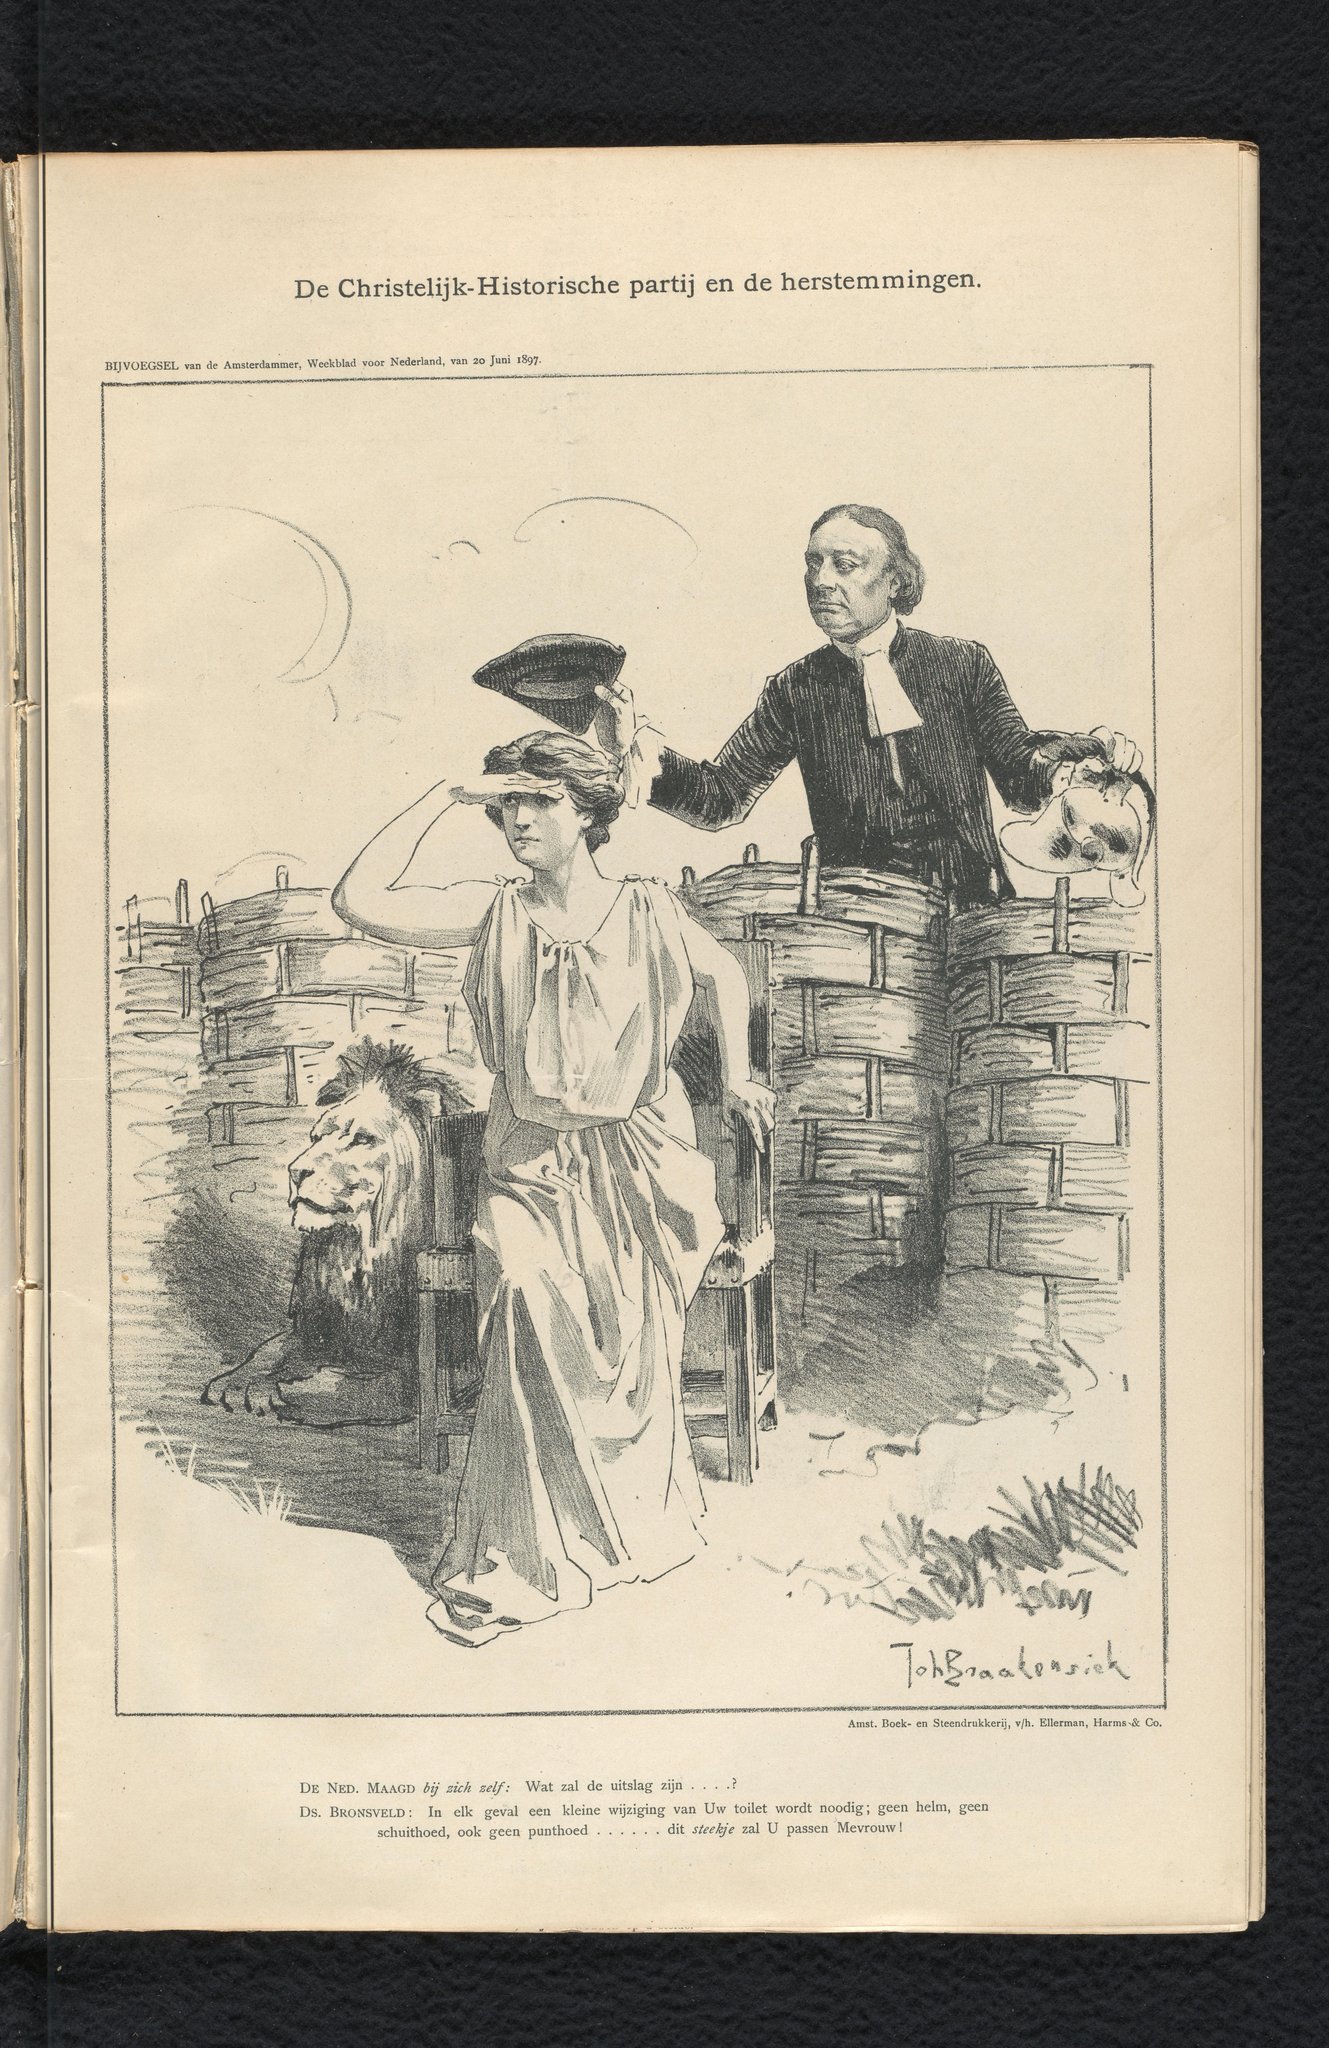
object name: cartoon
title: De Christelijk-Historische partij en de herstemmingen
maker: johan braakensiek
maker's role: draughtsman, print maker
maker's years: 1858-1940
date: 1897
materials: paper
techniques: lithograph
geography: netherlands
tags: utrecht, personifications of countries, nations, states, districts, etc., political caricatures and satires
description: Dominee Andries Bronsveld van de Christelijk-Historische Kiezersbond geeft de Nederlandse Maagd een nieuw hoofddeksel. Bij de Tweede Kamerverkiezingen van 1897.